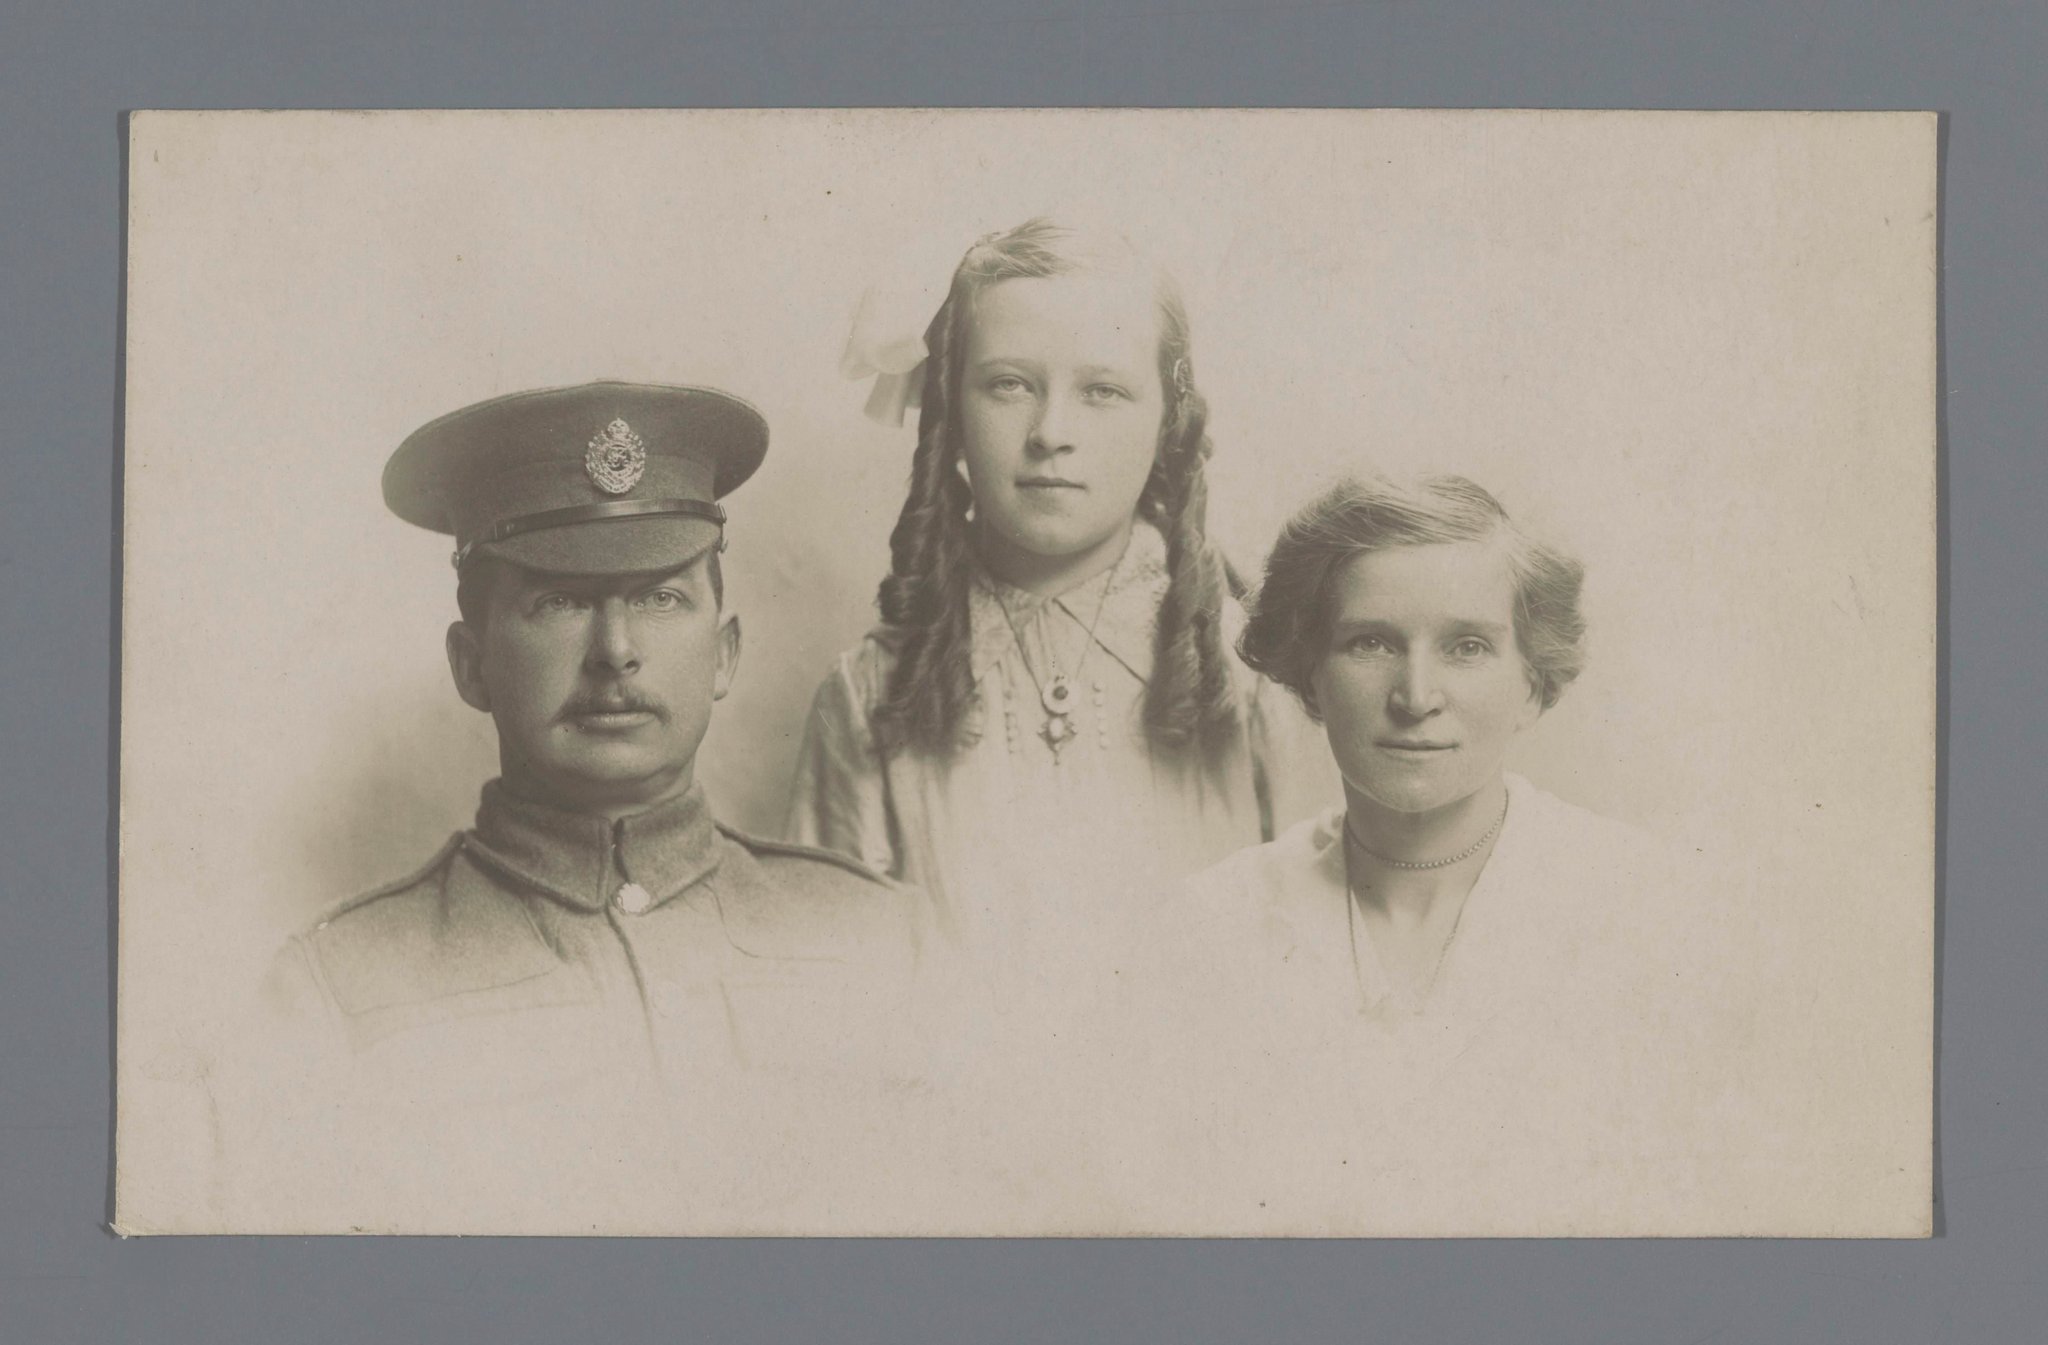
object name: ansichtkaart, prentbriefkaart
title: Portret van een onbekend gezin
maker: Anonymous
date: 1910-1920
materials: photographic support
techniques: gelatin silver print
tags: family group, especially parents with their child(ren)